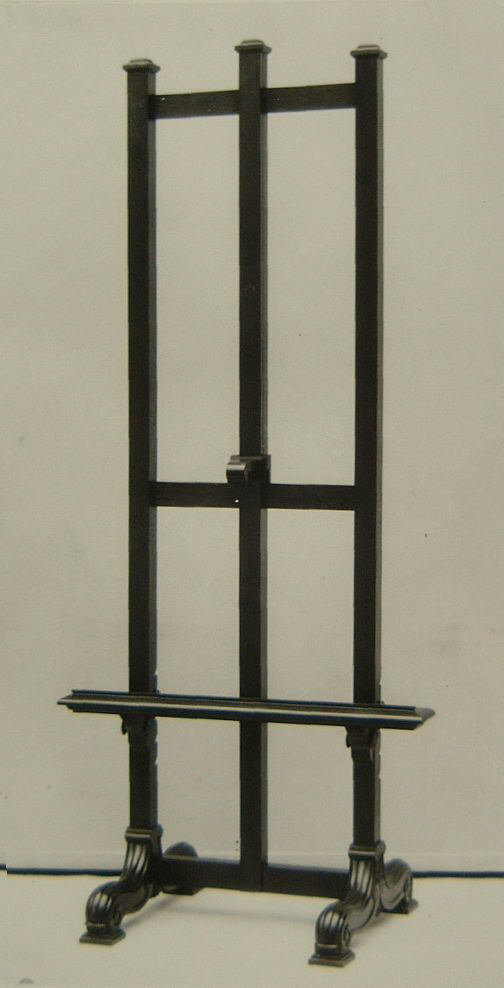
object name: easel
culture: american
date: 1890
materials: wood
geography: united states